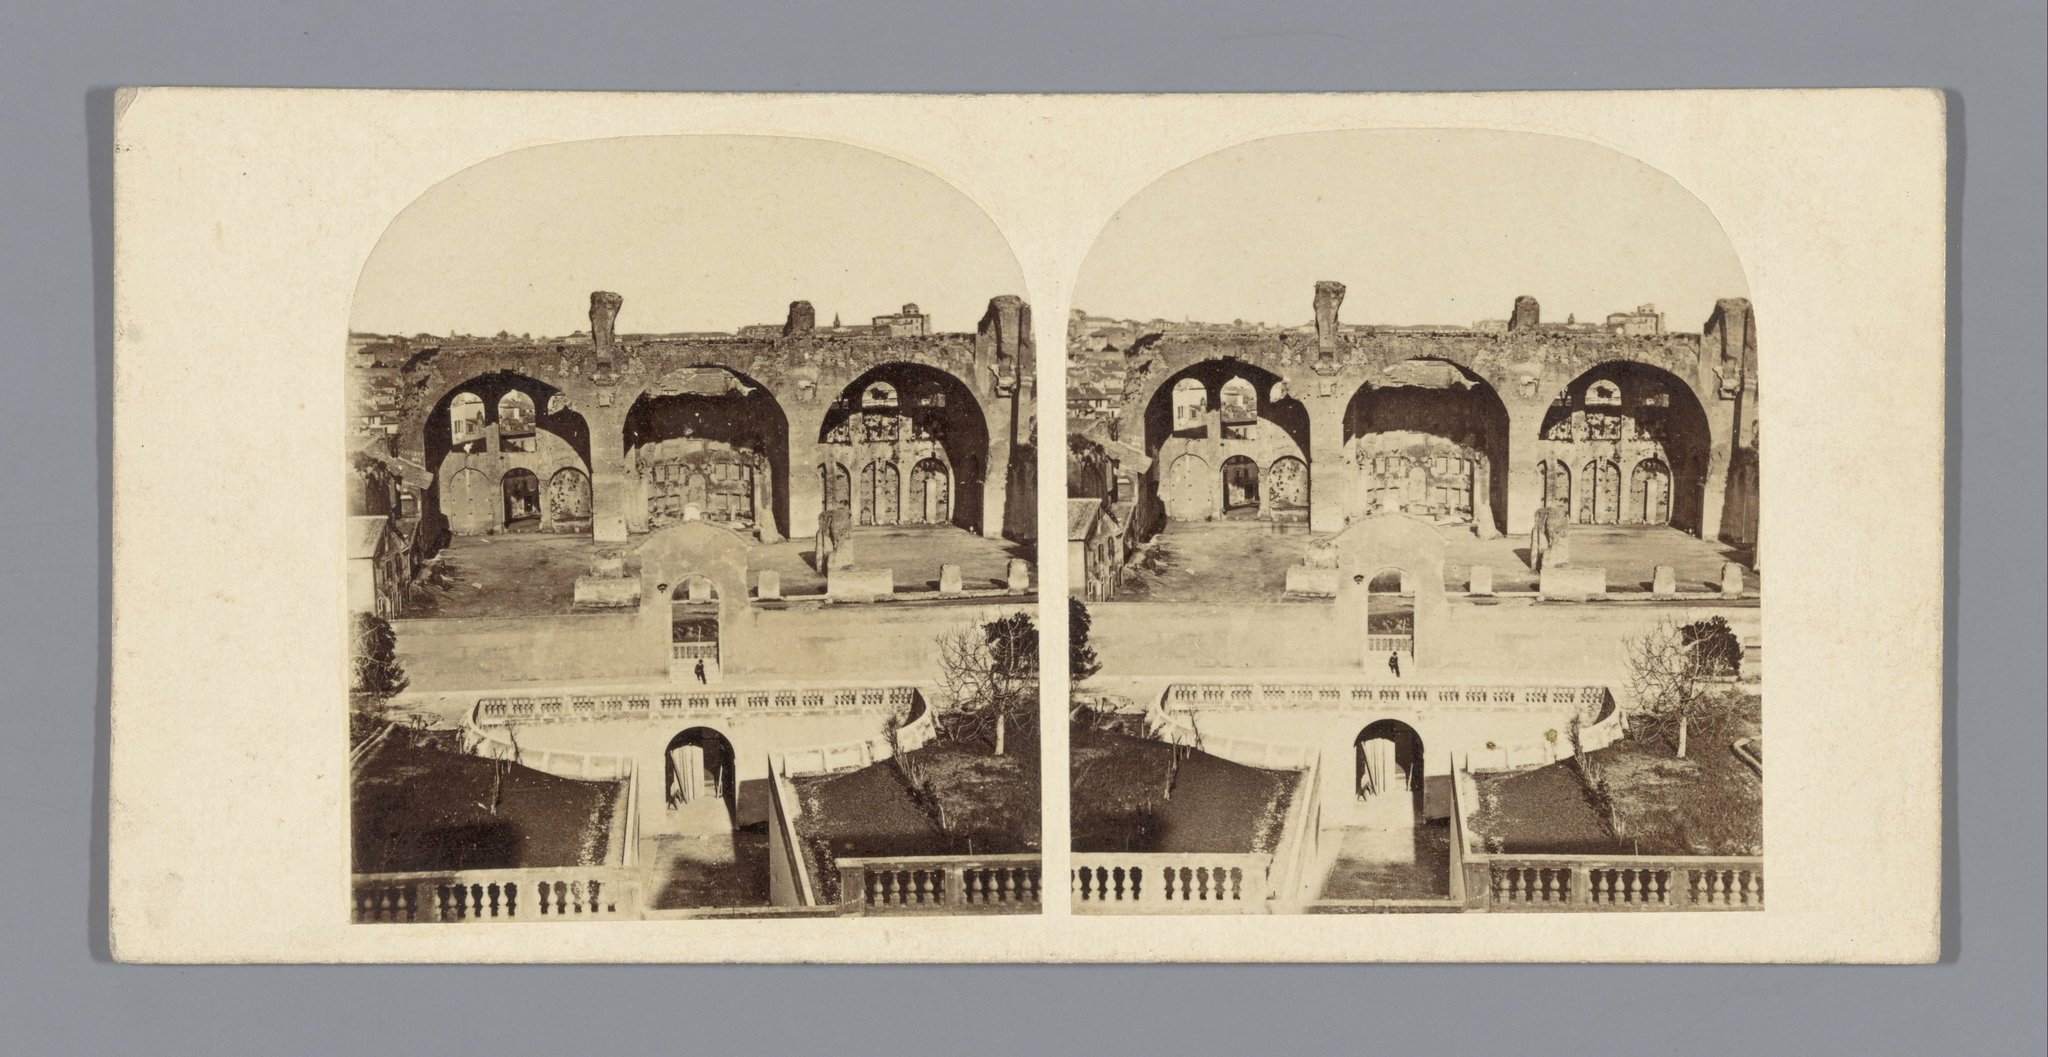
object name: stereograph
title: Gezicht op de Basilica van Maxentius te Rome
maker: Anonymous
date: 1850-1880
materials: cardboard, photographic support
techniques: albumen print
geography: rome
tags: square, place, circus, etc., ruin of a building ~ architecture, market-hall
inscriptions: inscription: ‘Basilique de Constantin Rome’